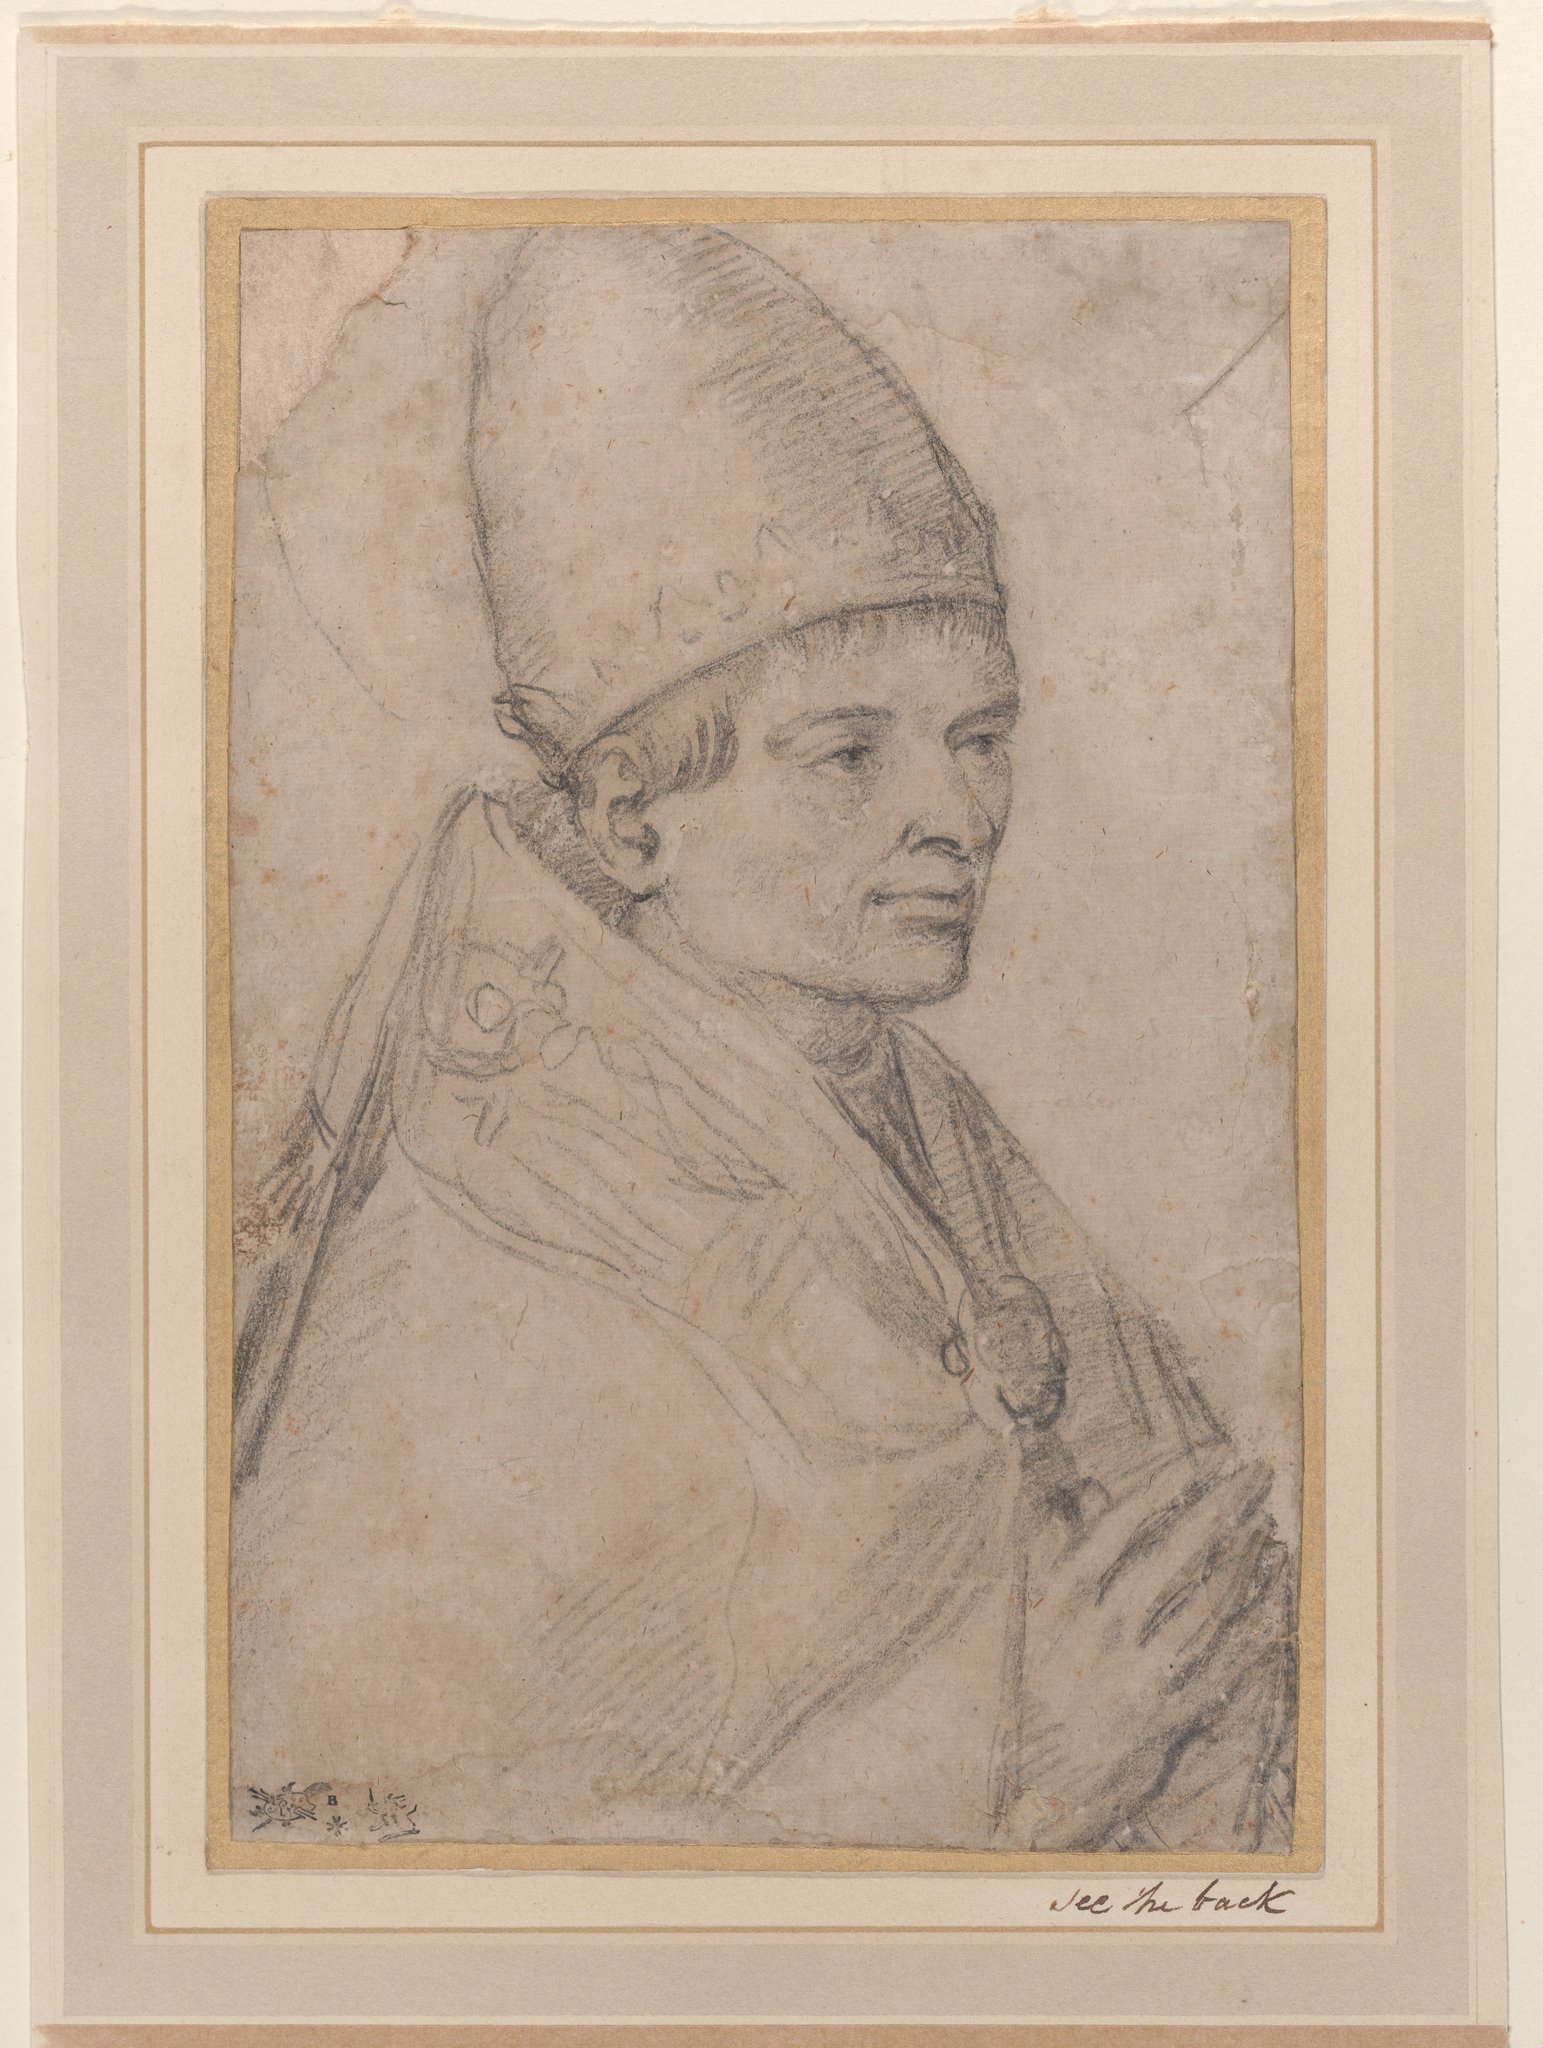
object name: drawing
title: Portrait of a pope, half-length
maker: anonymous, central-italian, 16th century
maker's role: artist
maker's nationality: italian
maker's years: 1500-1600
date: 1501-1600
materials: chalk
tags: men,portraits,popes